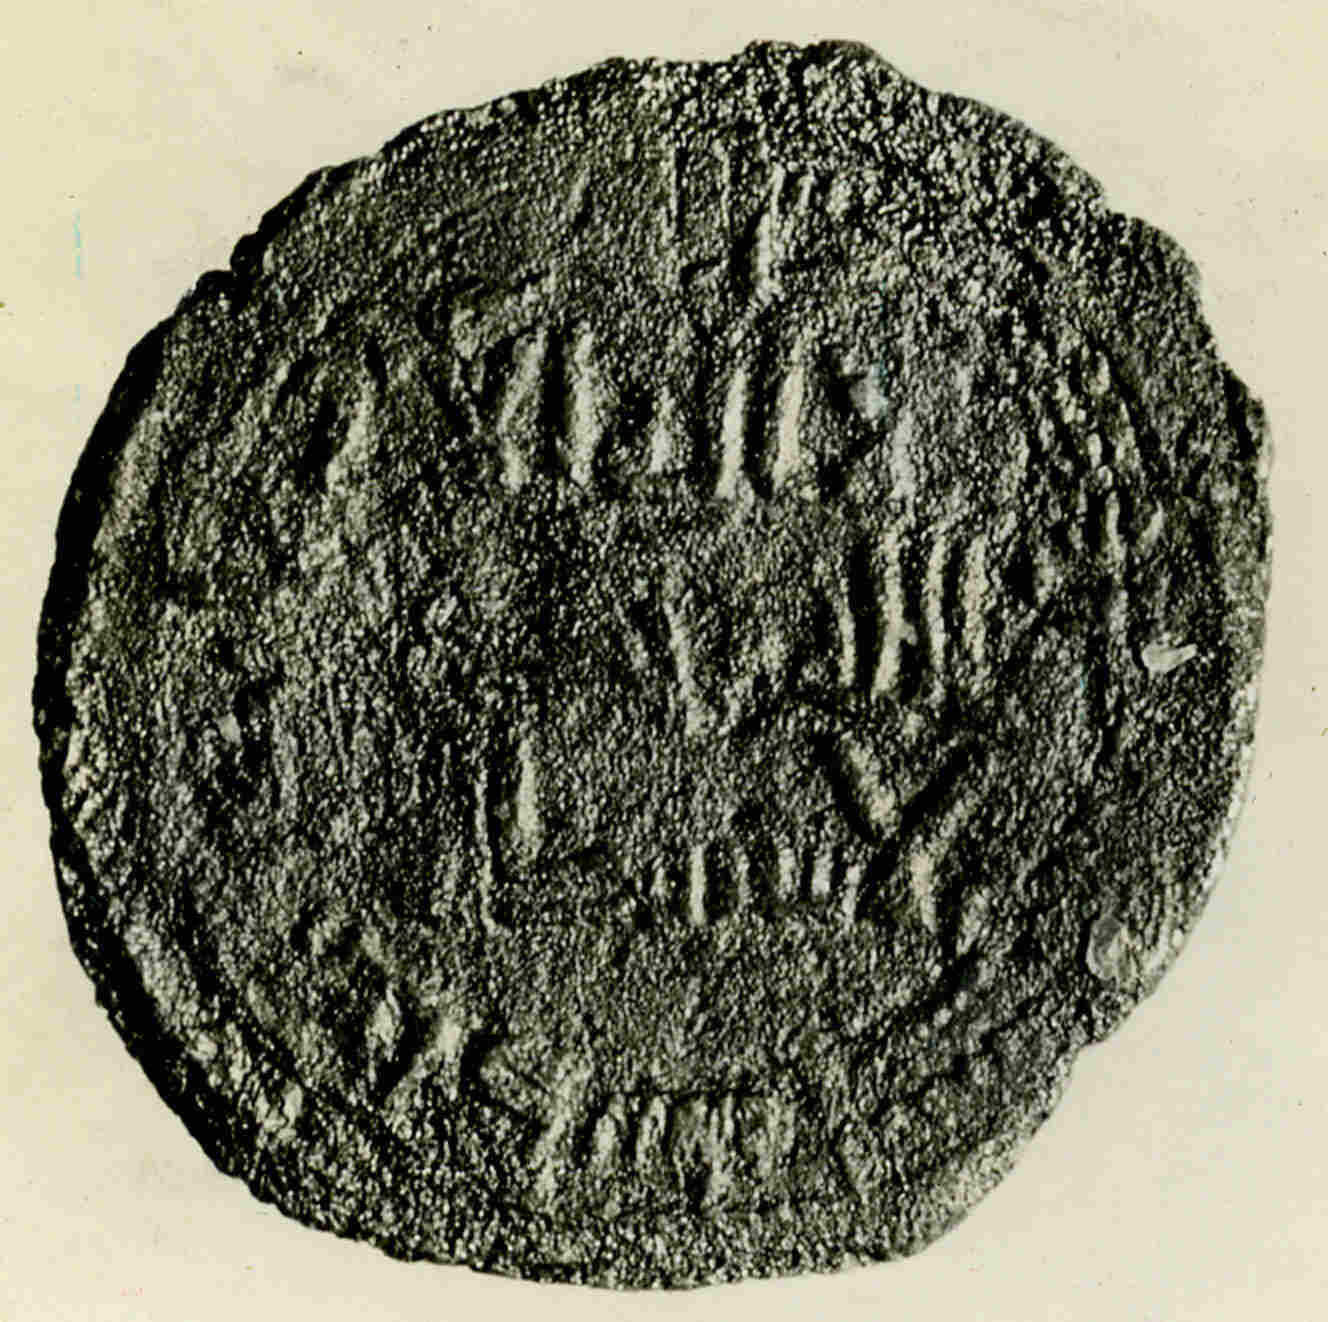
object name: coin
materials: copper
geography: iran